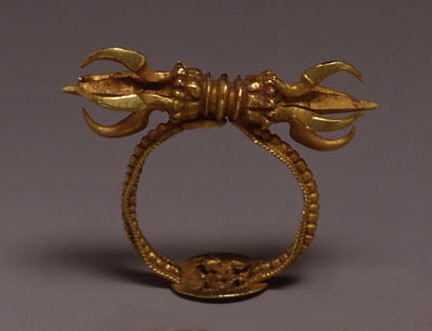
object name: ring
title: Ring with Bezel Composed of Double Vajra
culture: indonesian, javanese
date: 701-933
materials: gold